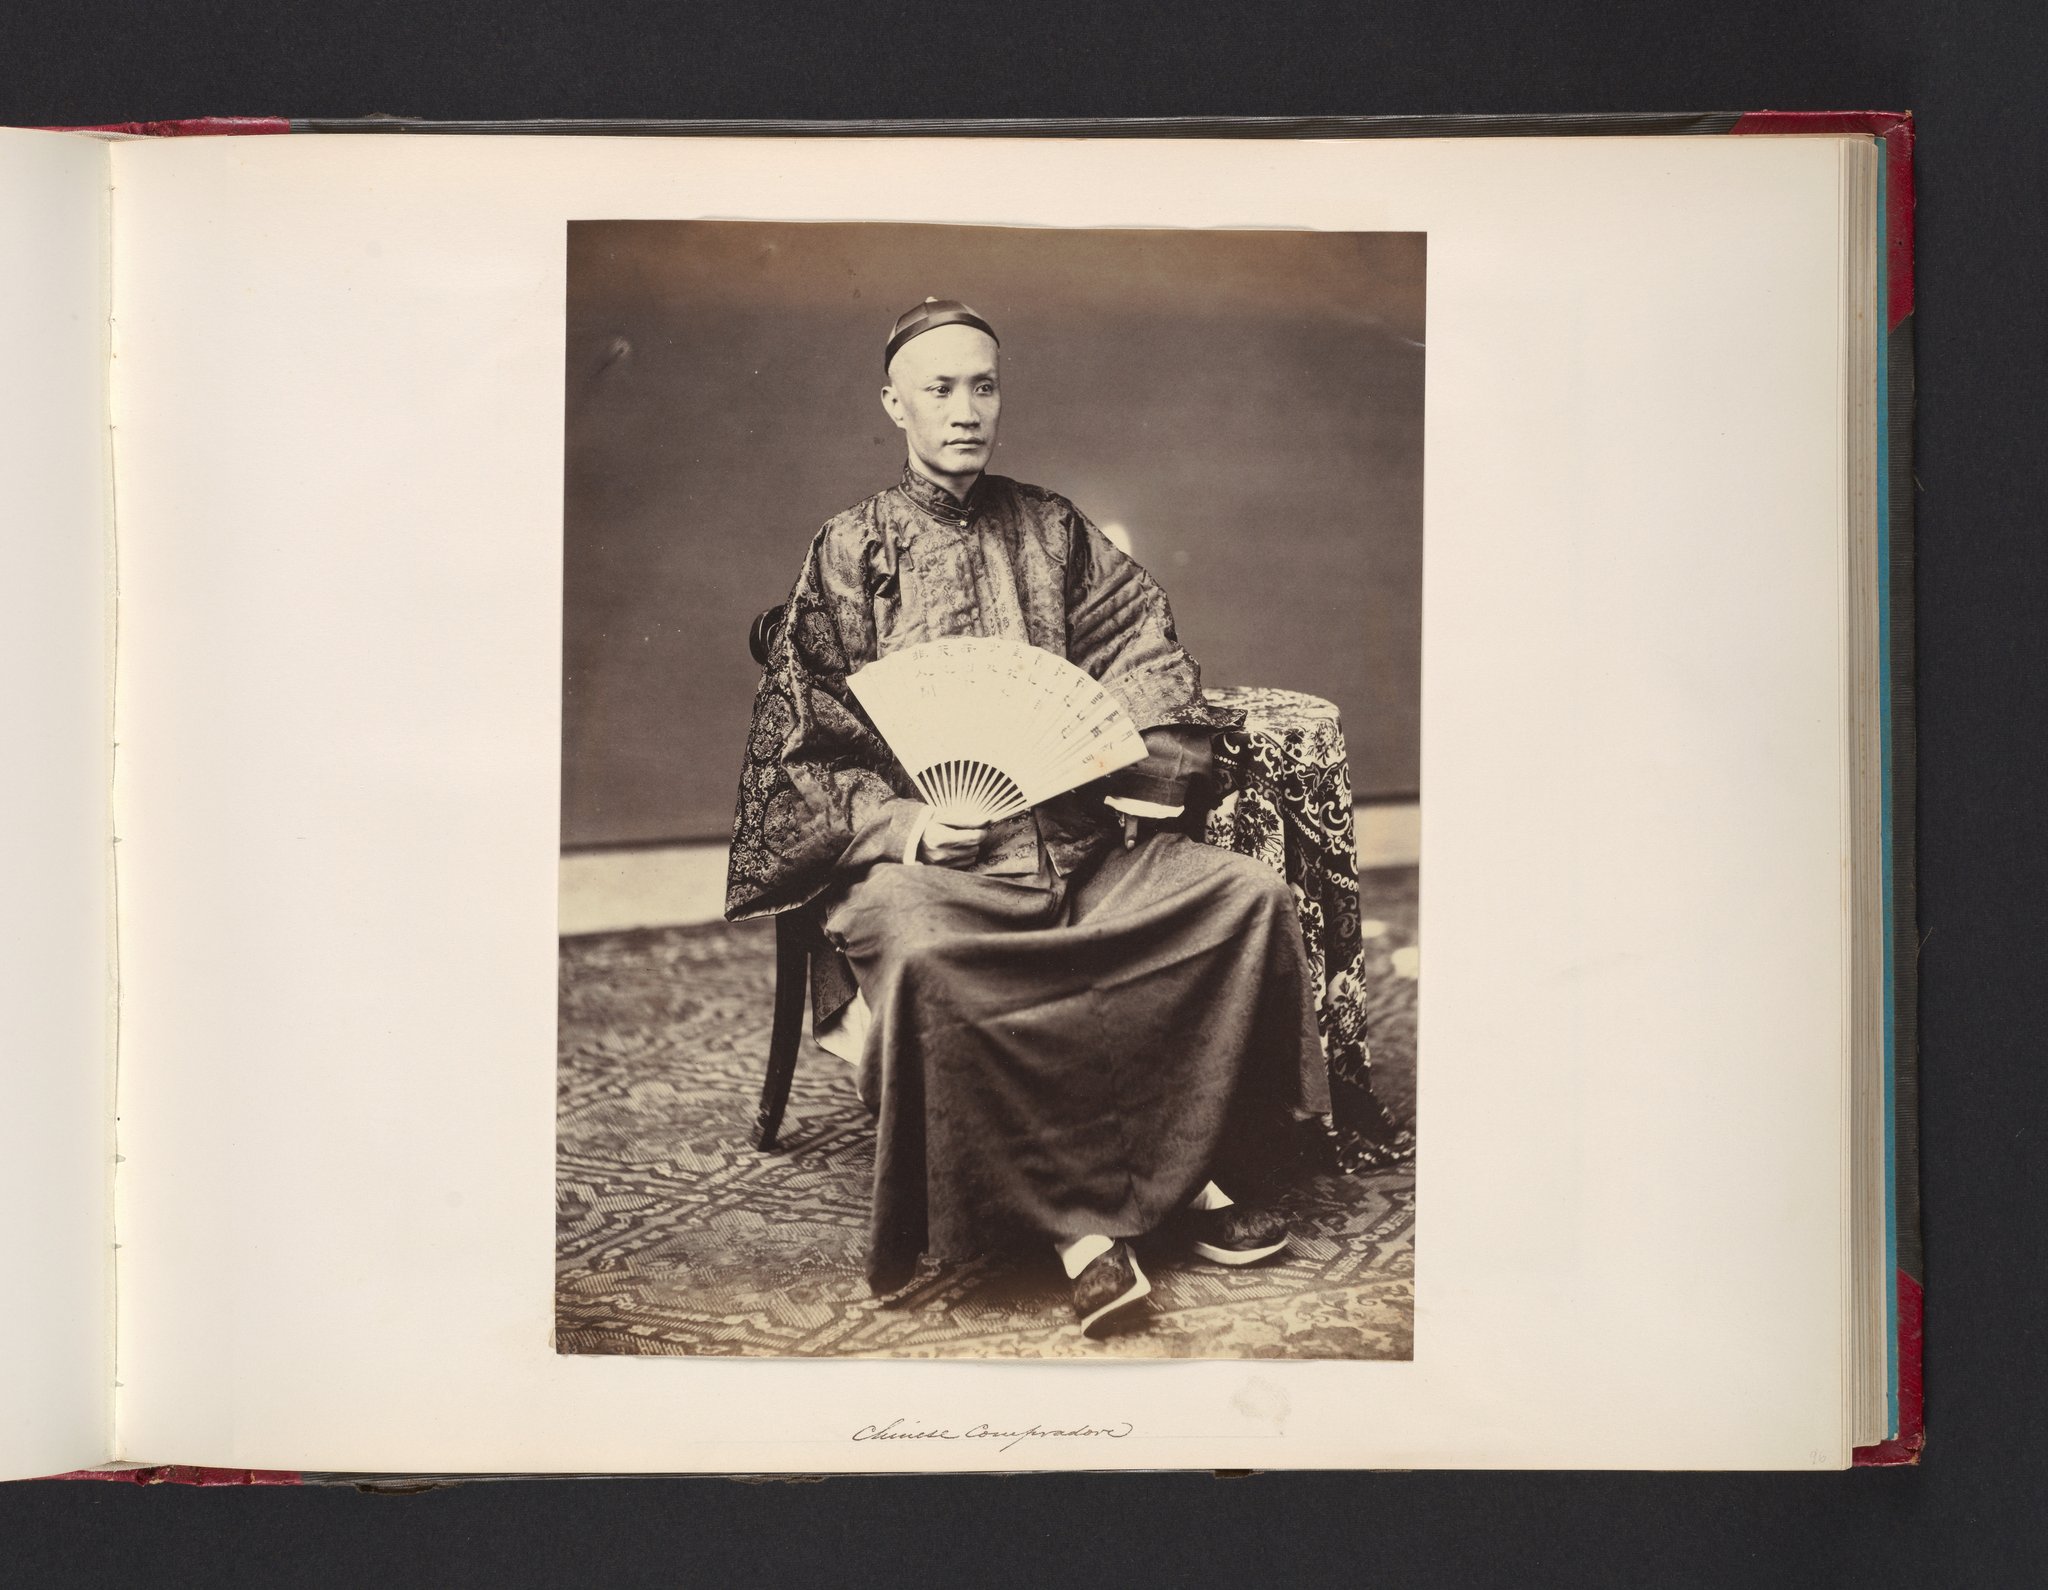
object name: photograph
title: Chinese Comprador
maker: john thomson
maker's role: artist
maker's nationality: british, scottish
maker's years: 1837-1921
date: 1865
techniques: albumen silver print, glass negative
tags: men,portraits